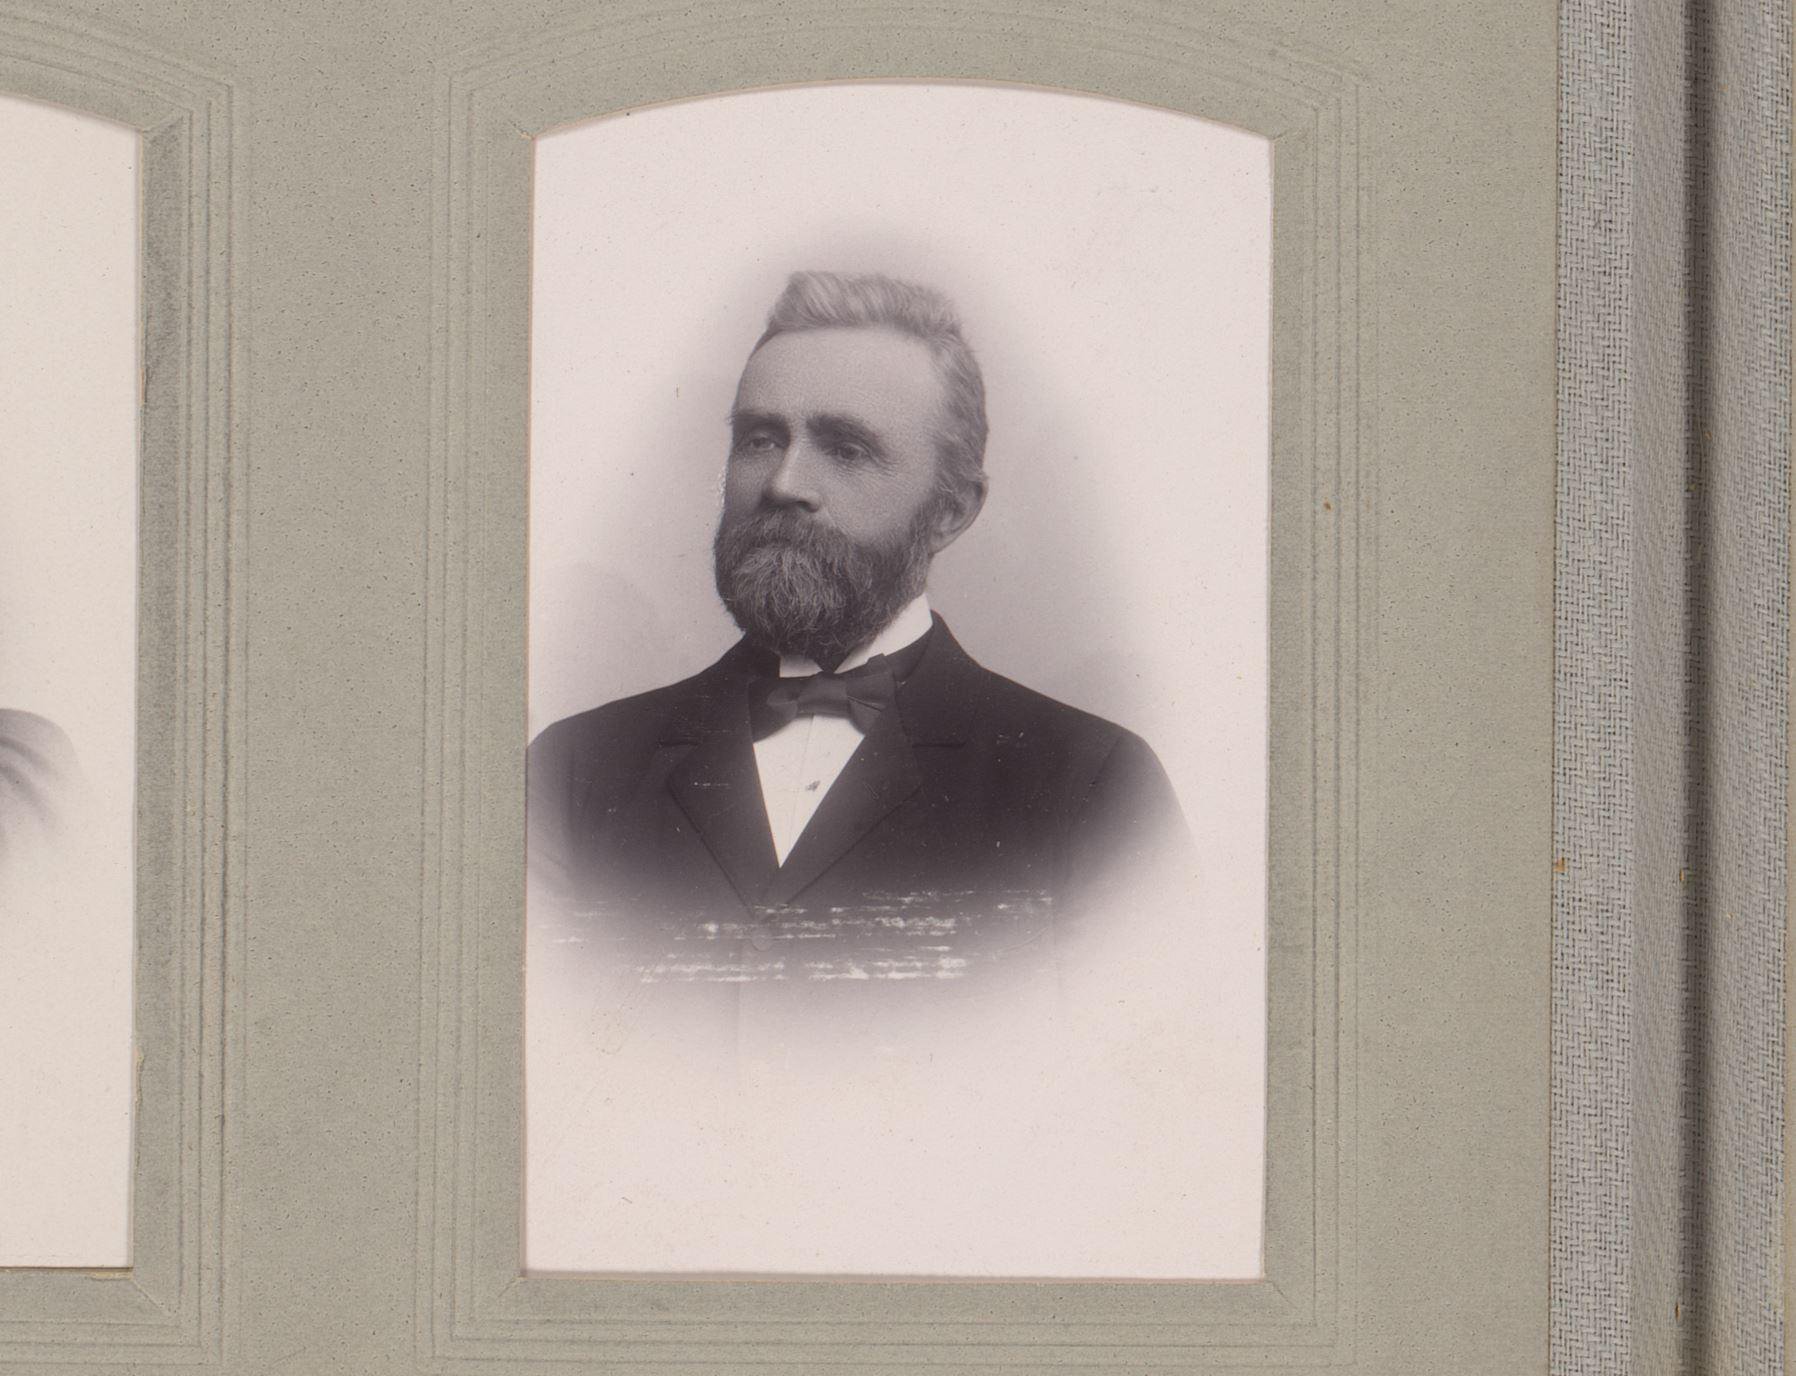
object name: photograph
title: Portret van een man met snor en baard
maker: hedvig rosendahl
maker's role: fotograaf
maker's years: 1867-1929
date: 1880-1920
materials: cardboard, photographic support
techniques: collodion silver print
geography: stockholm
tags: moustache, historical persons, beard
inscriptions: inscription: ‘Hedvig Rosendahls/ Atelier/ Stockholm/ Allm. Telef./ 42/ 10778/ Drotninggatan/ Allm. Telef./ & 51/ 11087/ Malmskilnadsgatan 48 c/ Allm. Tel. 6290./ Plåten förvaras för efterbeställning.’